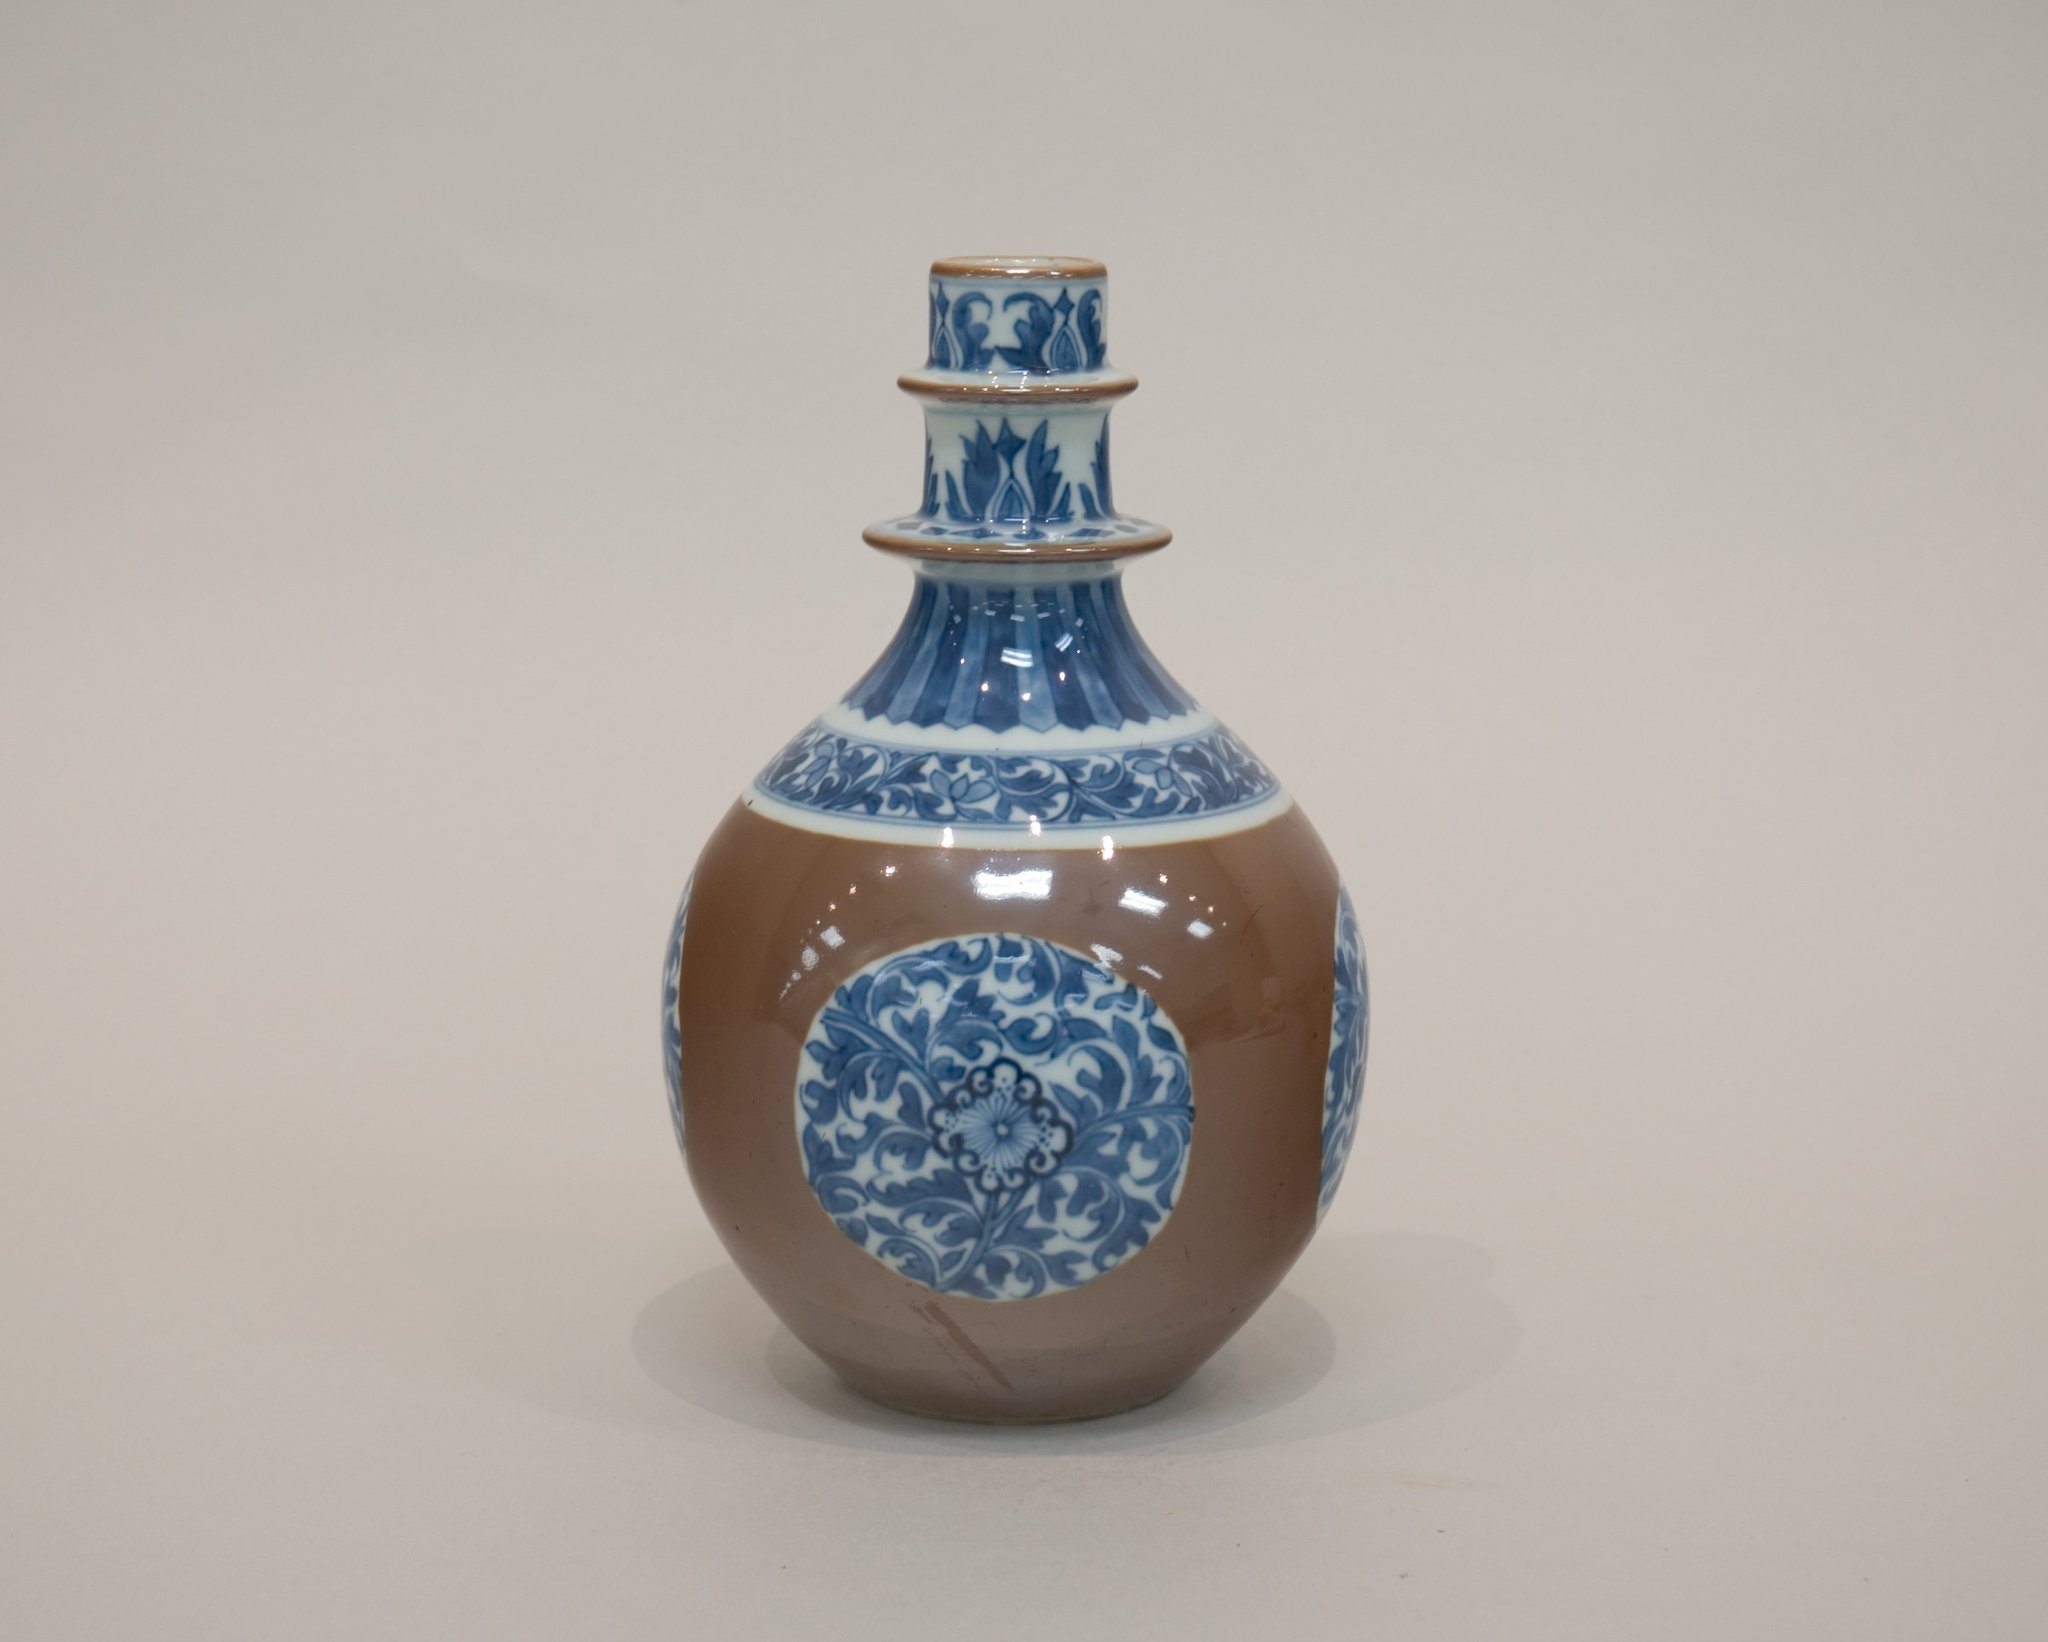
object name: bottle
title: Bottle for a water pipe (huqqa)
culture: chinese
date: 1667-1733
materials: cobalt, glaze, porcelain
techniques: painting, underglaze